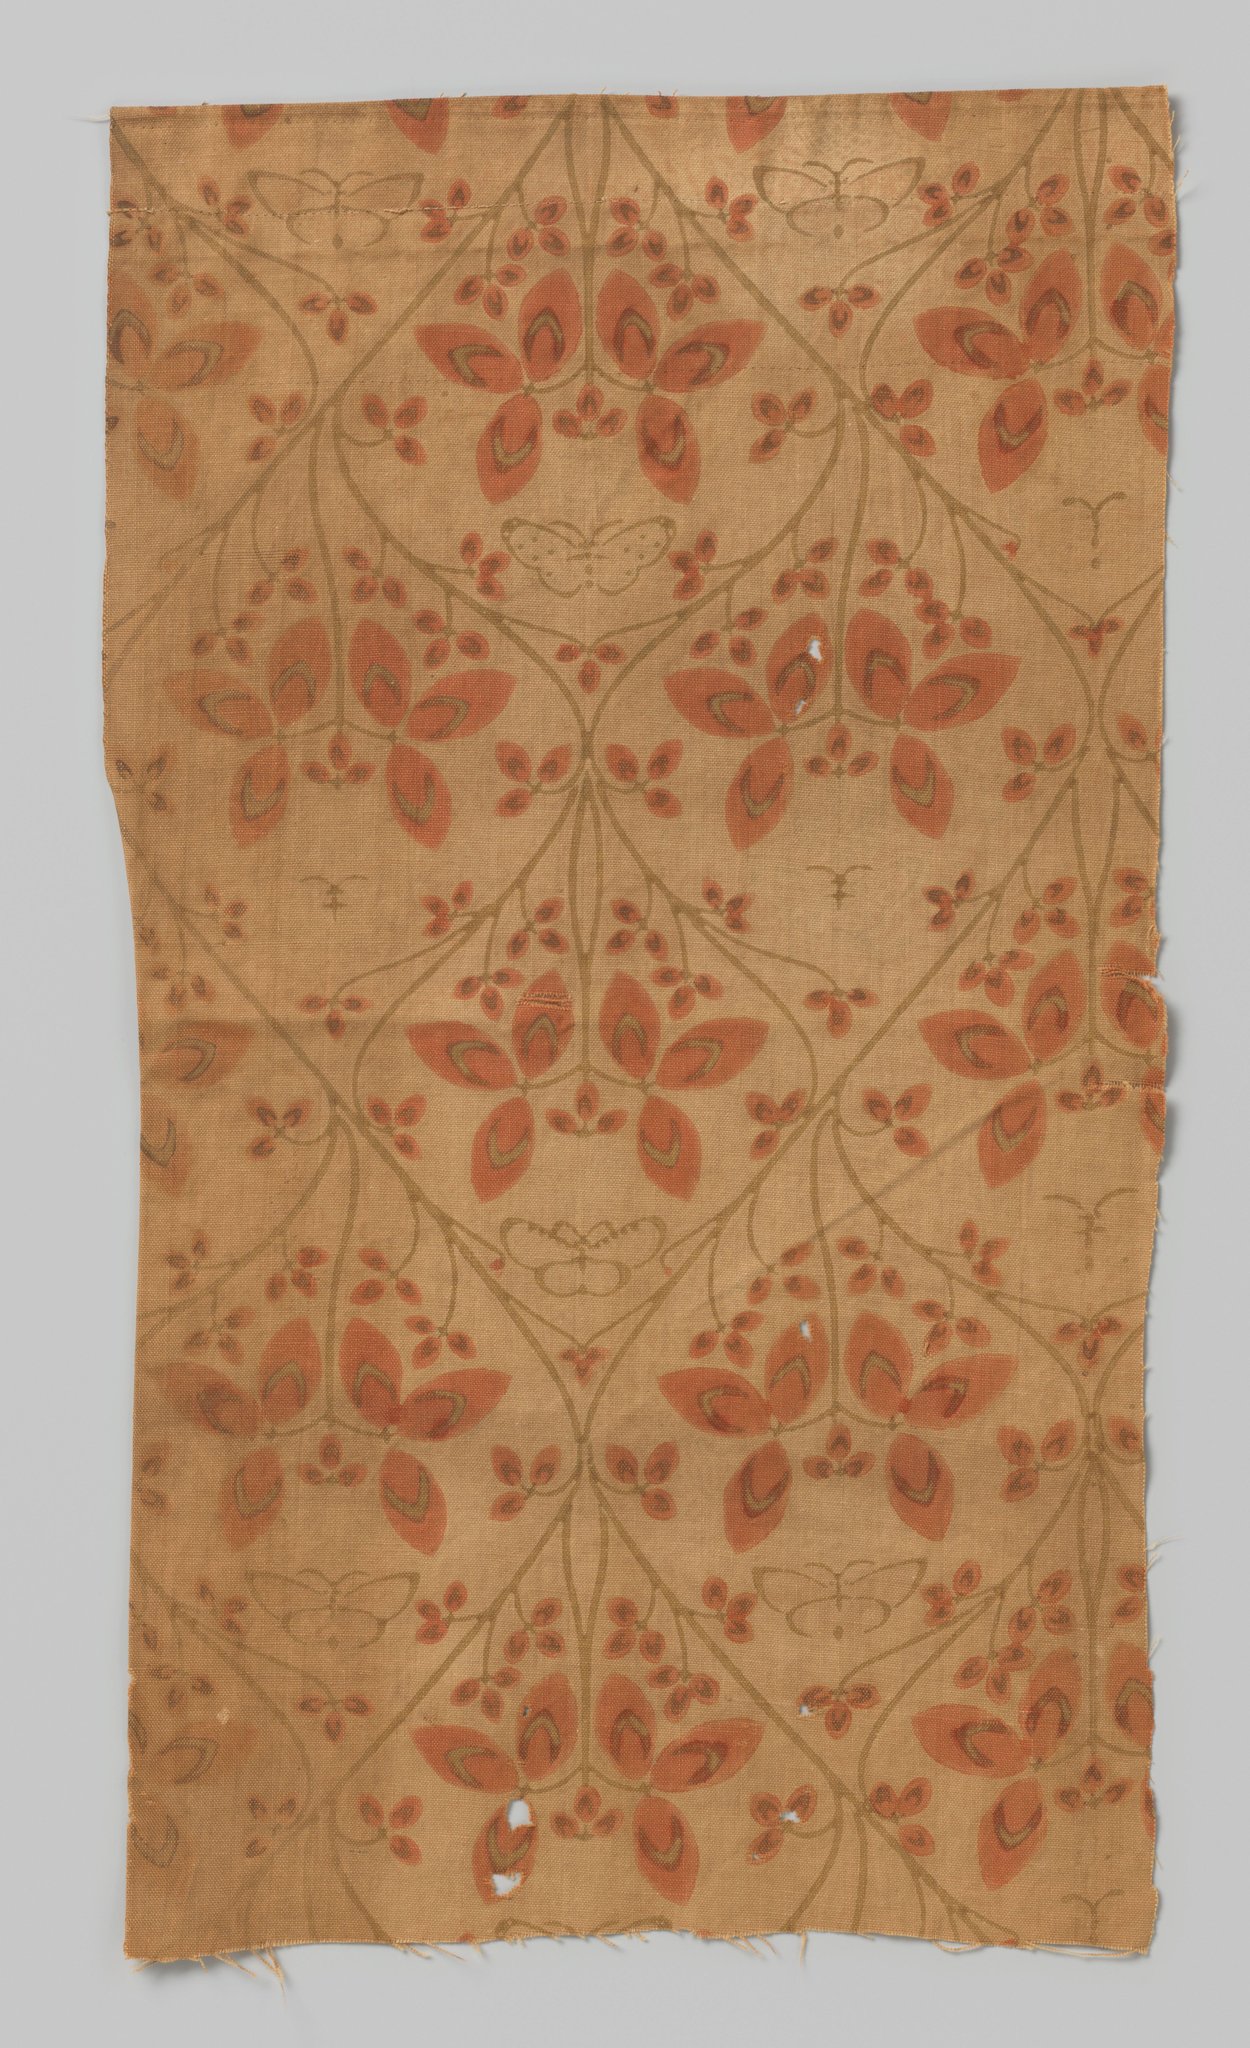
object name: upholstery fabric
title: Fragment bedrukte cretonne met patroon van klaver met vlinder binnen spitsovalen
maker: theo nieuwenhuis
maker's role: designer, draughtsman, print maker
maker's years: 1866-1951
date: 1900-1925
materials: linen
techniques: printing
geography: helmond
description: Fragment bedrukte cretonne met patroon van klaver met vlinder binnen spitsovalen in de kleuren rood, een vergane kleur, mosgroen en roze op naturel fond.